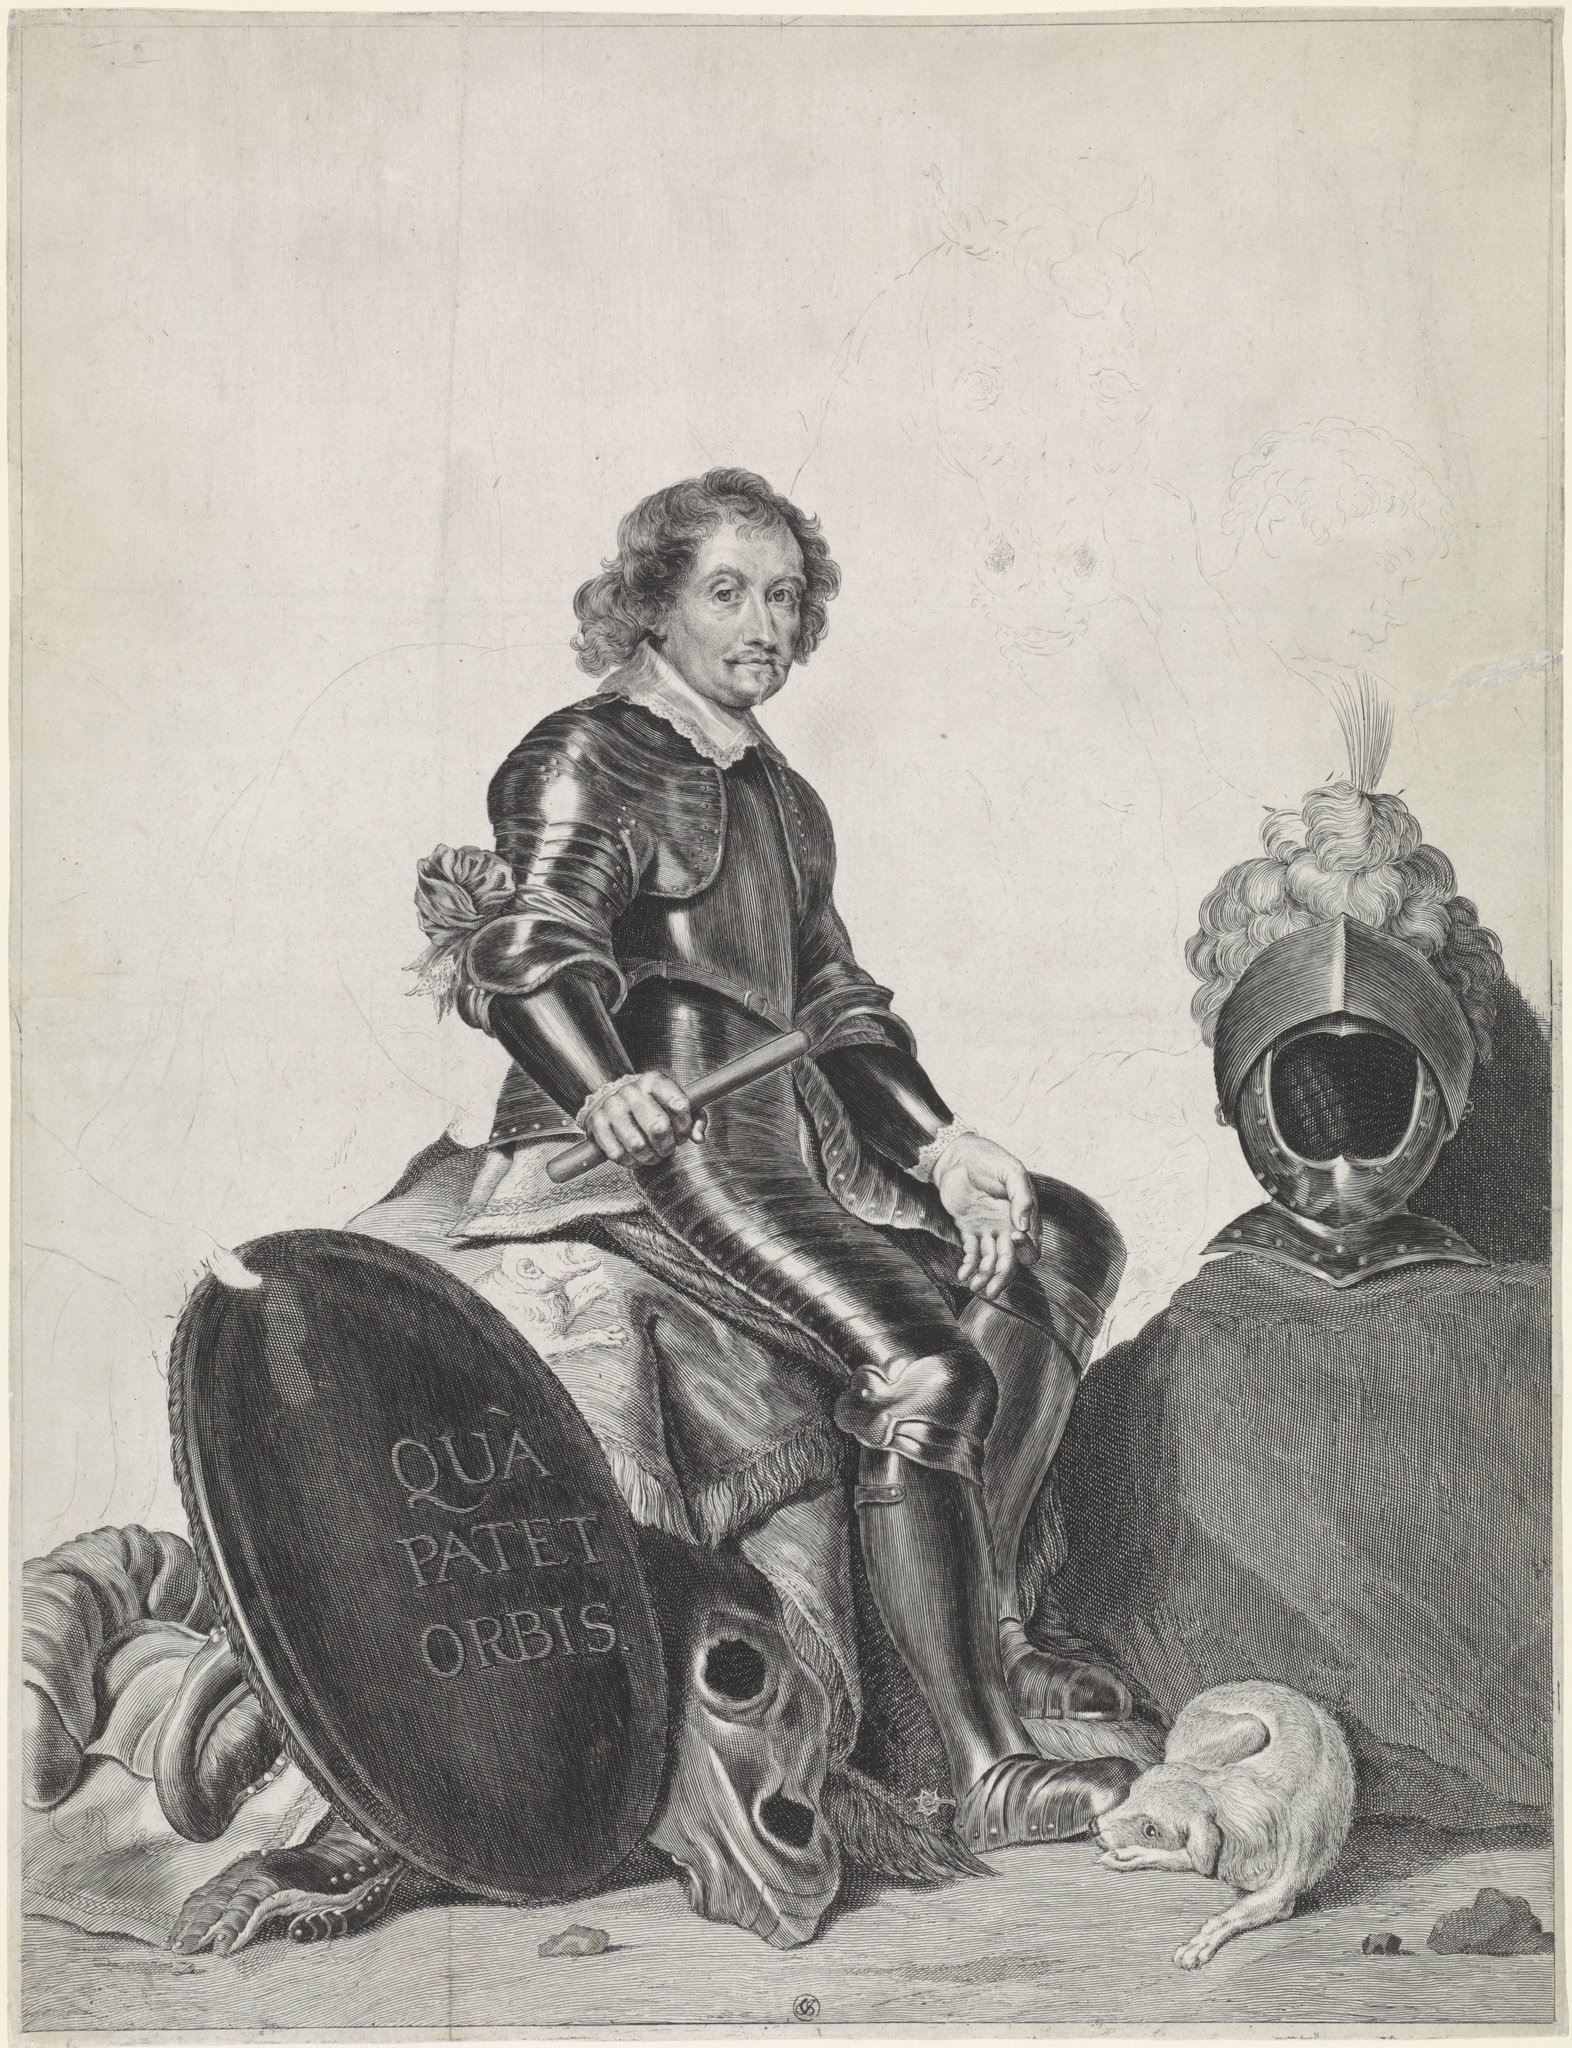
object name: print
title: Portret van Johan Maurits van Nassau-Siegen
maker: theodor matham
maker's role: draughtsman, print maker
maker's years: 1605-1676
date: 1635-1676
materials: paper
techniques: drypoint, engraving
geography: northern netherlands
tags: earl, johan maurits graaf van nassau-siegen, helmet, protective weapons: shield, armour, baton of general, armorial bearing, heraldry, dog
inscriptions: collector's mark: Lugt 12, collector's mark: Lugt 573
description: Portret van de gouverneur in Brazilië, Johan Maurits van Nassau-Siegen, in wapenrusting. Aan zijn voeten een hond en naast hem een schild waarop het motto: Qua patet orbis. Rechts een helm. Op de achtergrond de aanzet voor een figuur met een paard.